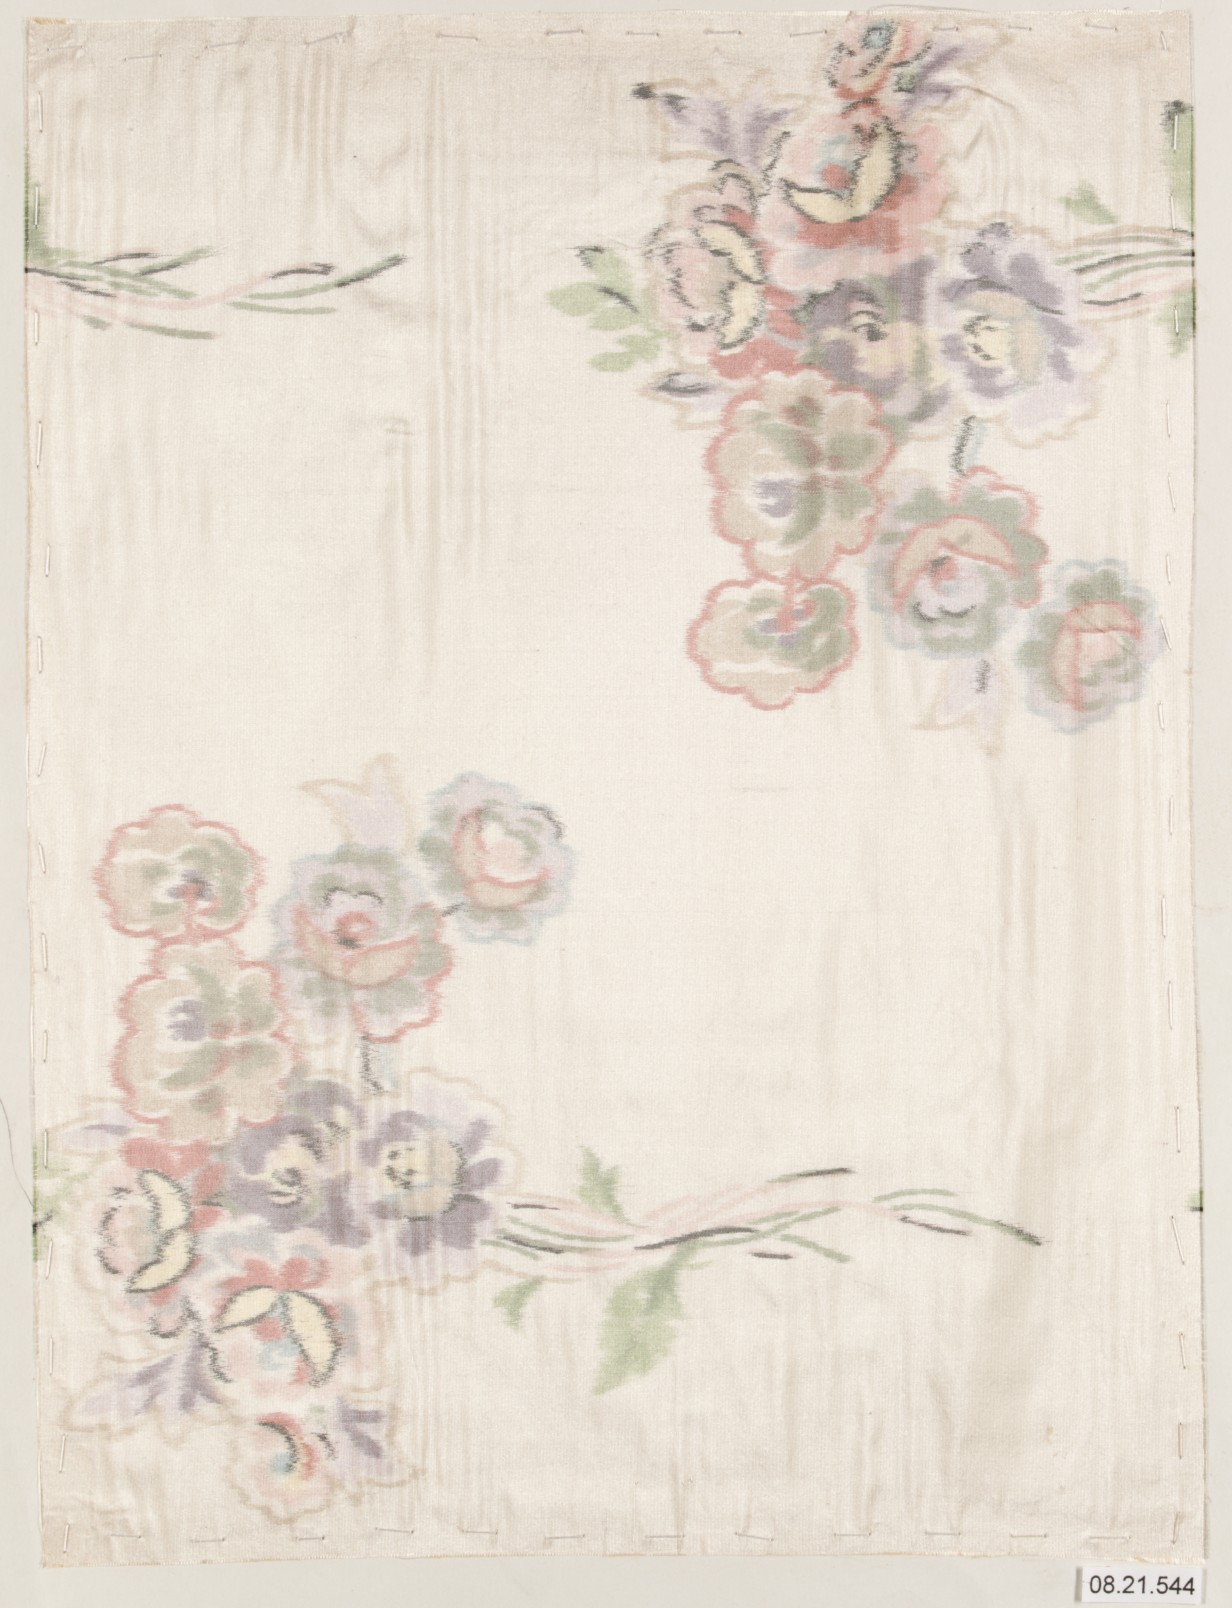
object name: textile sample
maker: Anonymous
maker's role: designer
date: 1900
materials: silk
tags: flowers